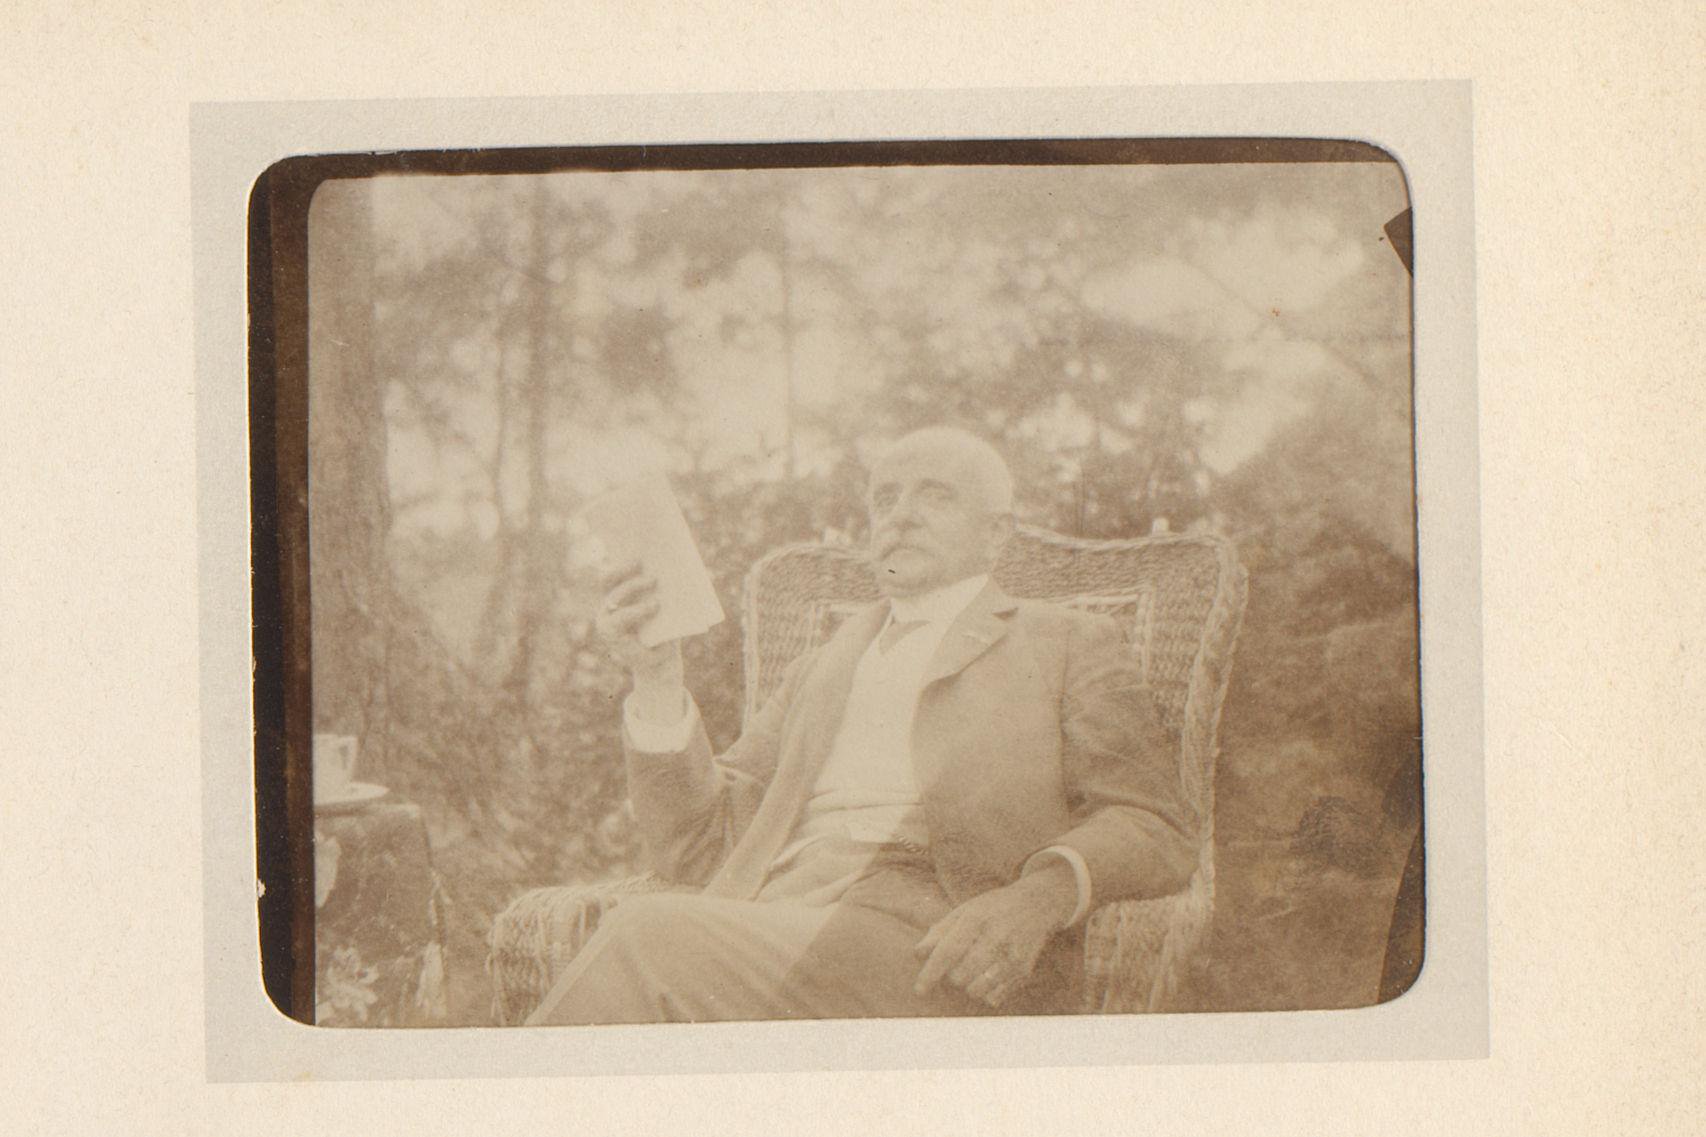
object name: photograph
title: Portret van een man zittend in een tuinstoel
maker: liesbeth overhoff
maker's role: fotograaf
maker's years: 1895-1969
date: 1911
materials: paper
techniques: gelatin silver print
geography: hilversum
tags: sitting figure, historical persons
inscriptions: inscription: ‘Hilversum Augustus 31 1911.’